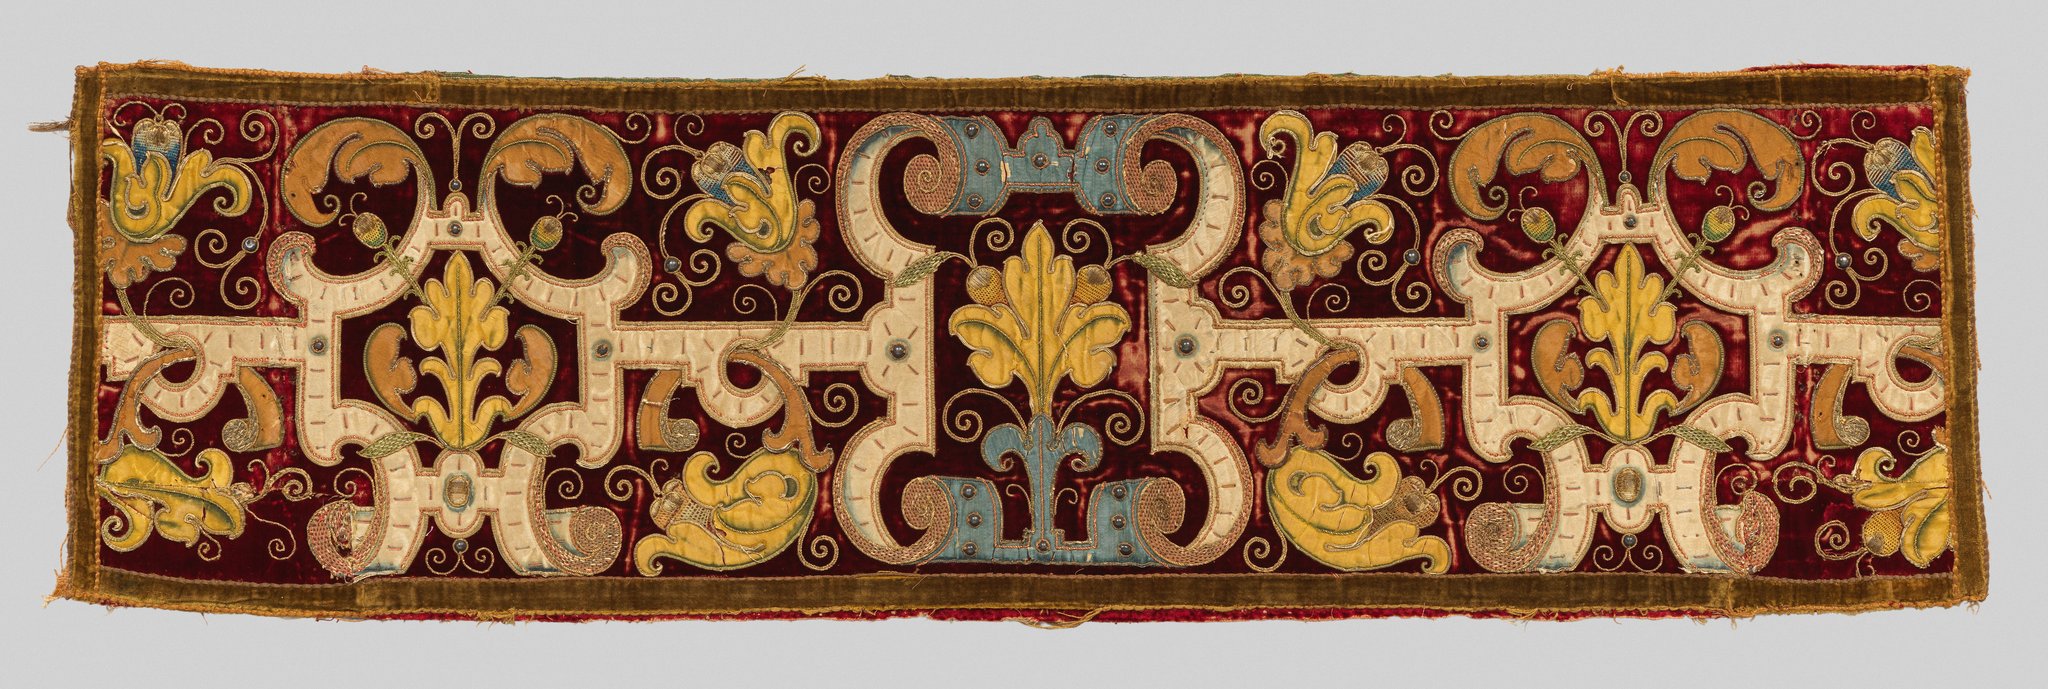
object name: band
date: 1601-1700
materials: metal thread, silk, velvet